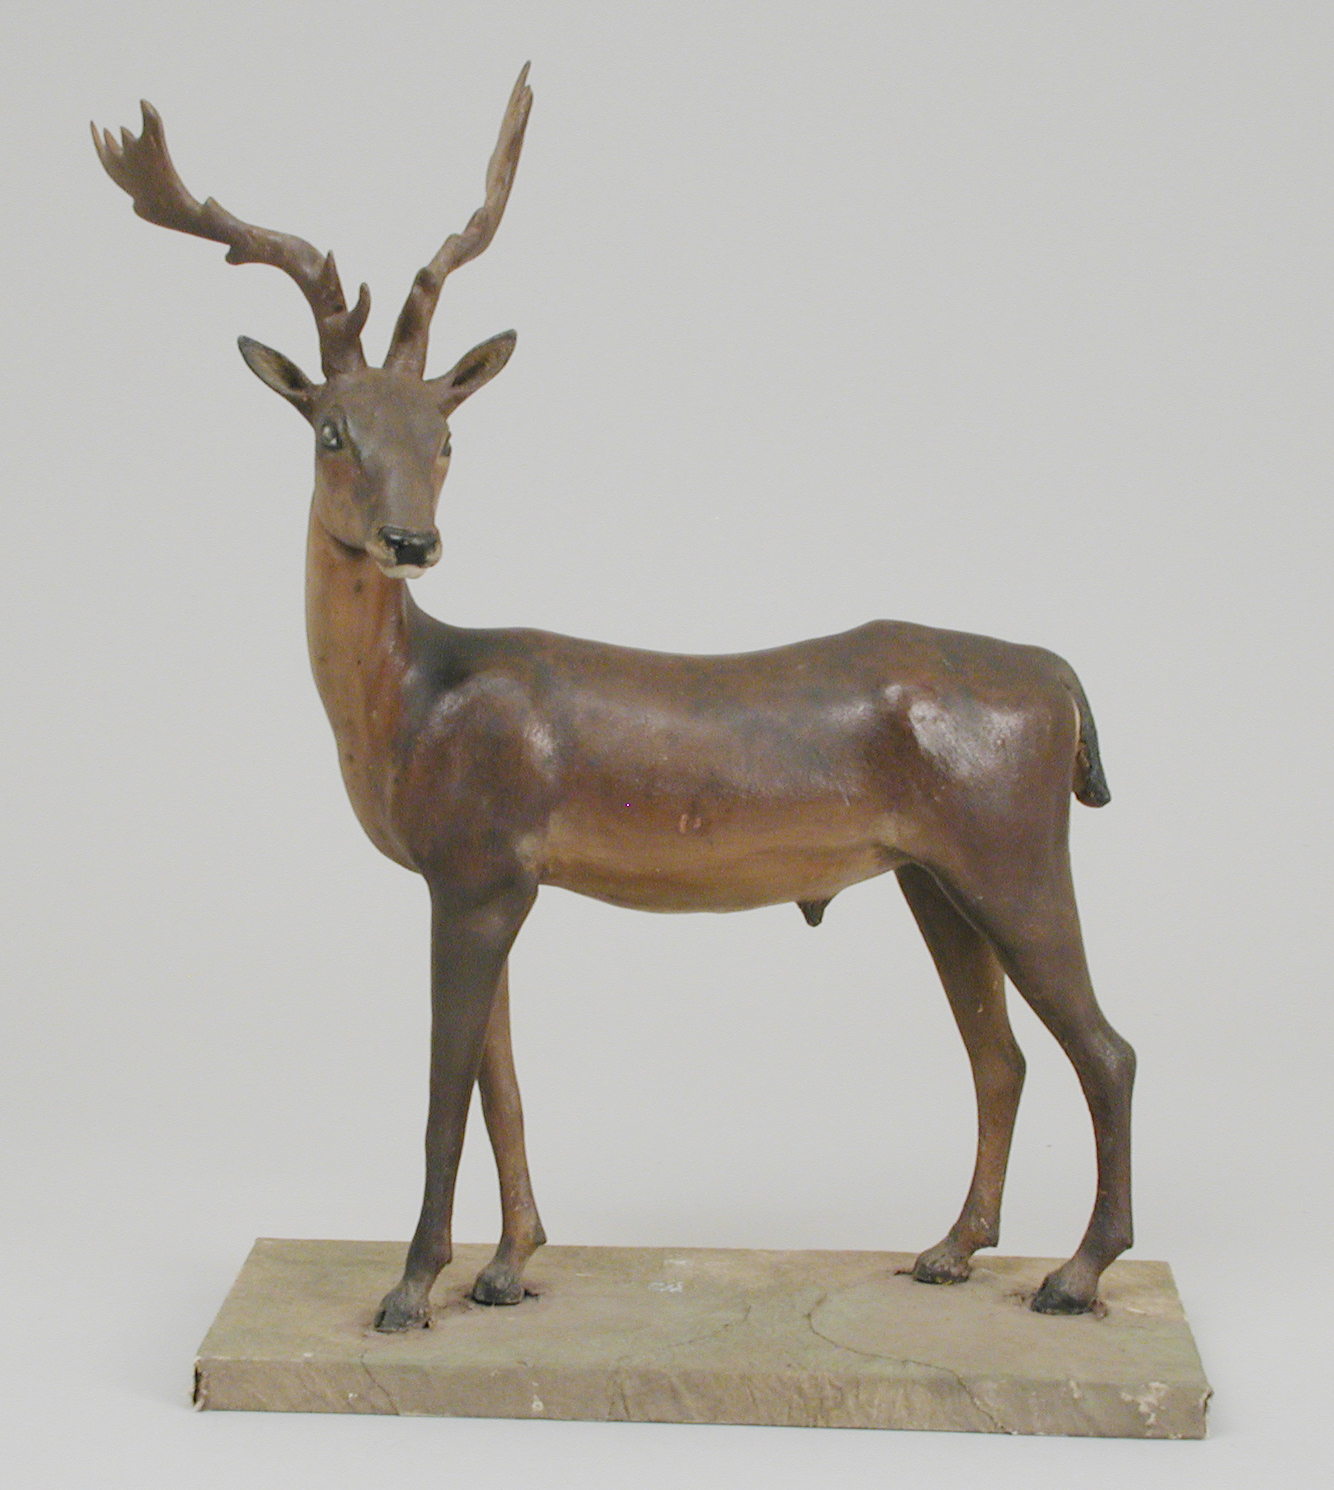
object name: crèche figure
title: Antlered buck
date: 1701-1900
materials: glass, terracotta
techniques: polychrome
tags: deer